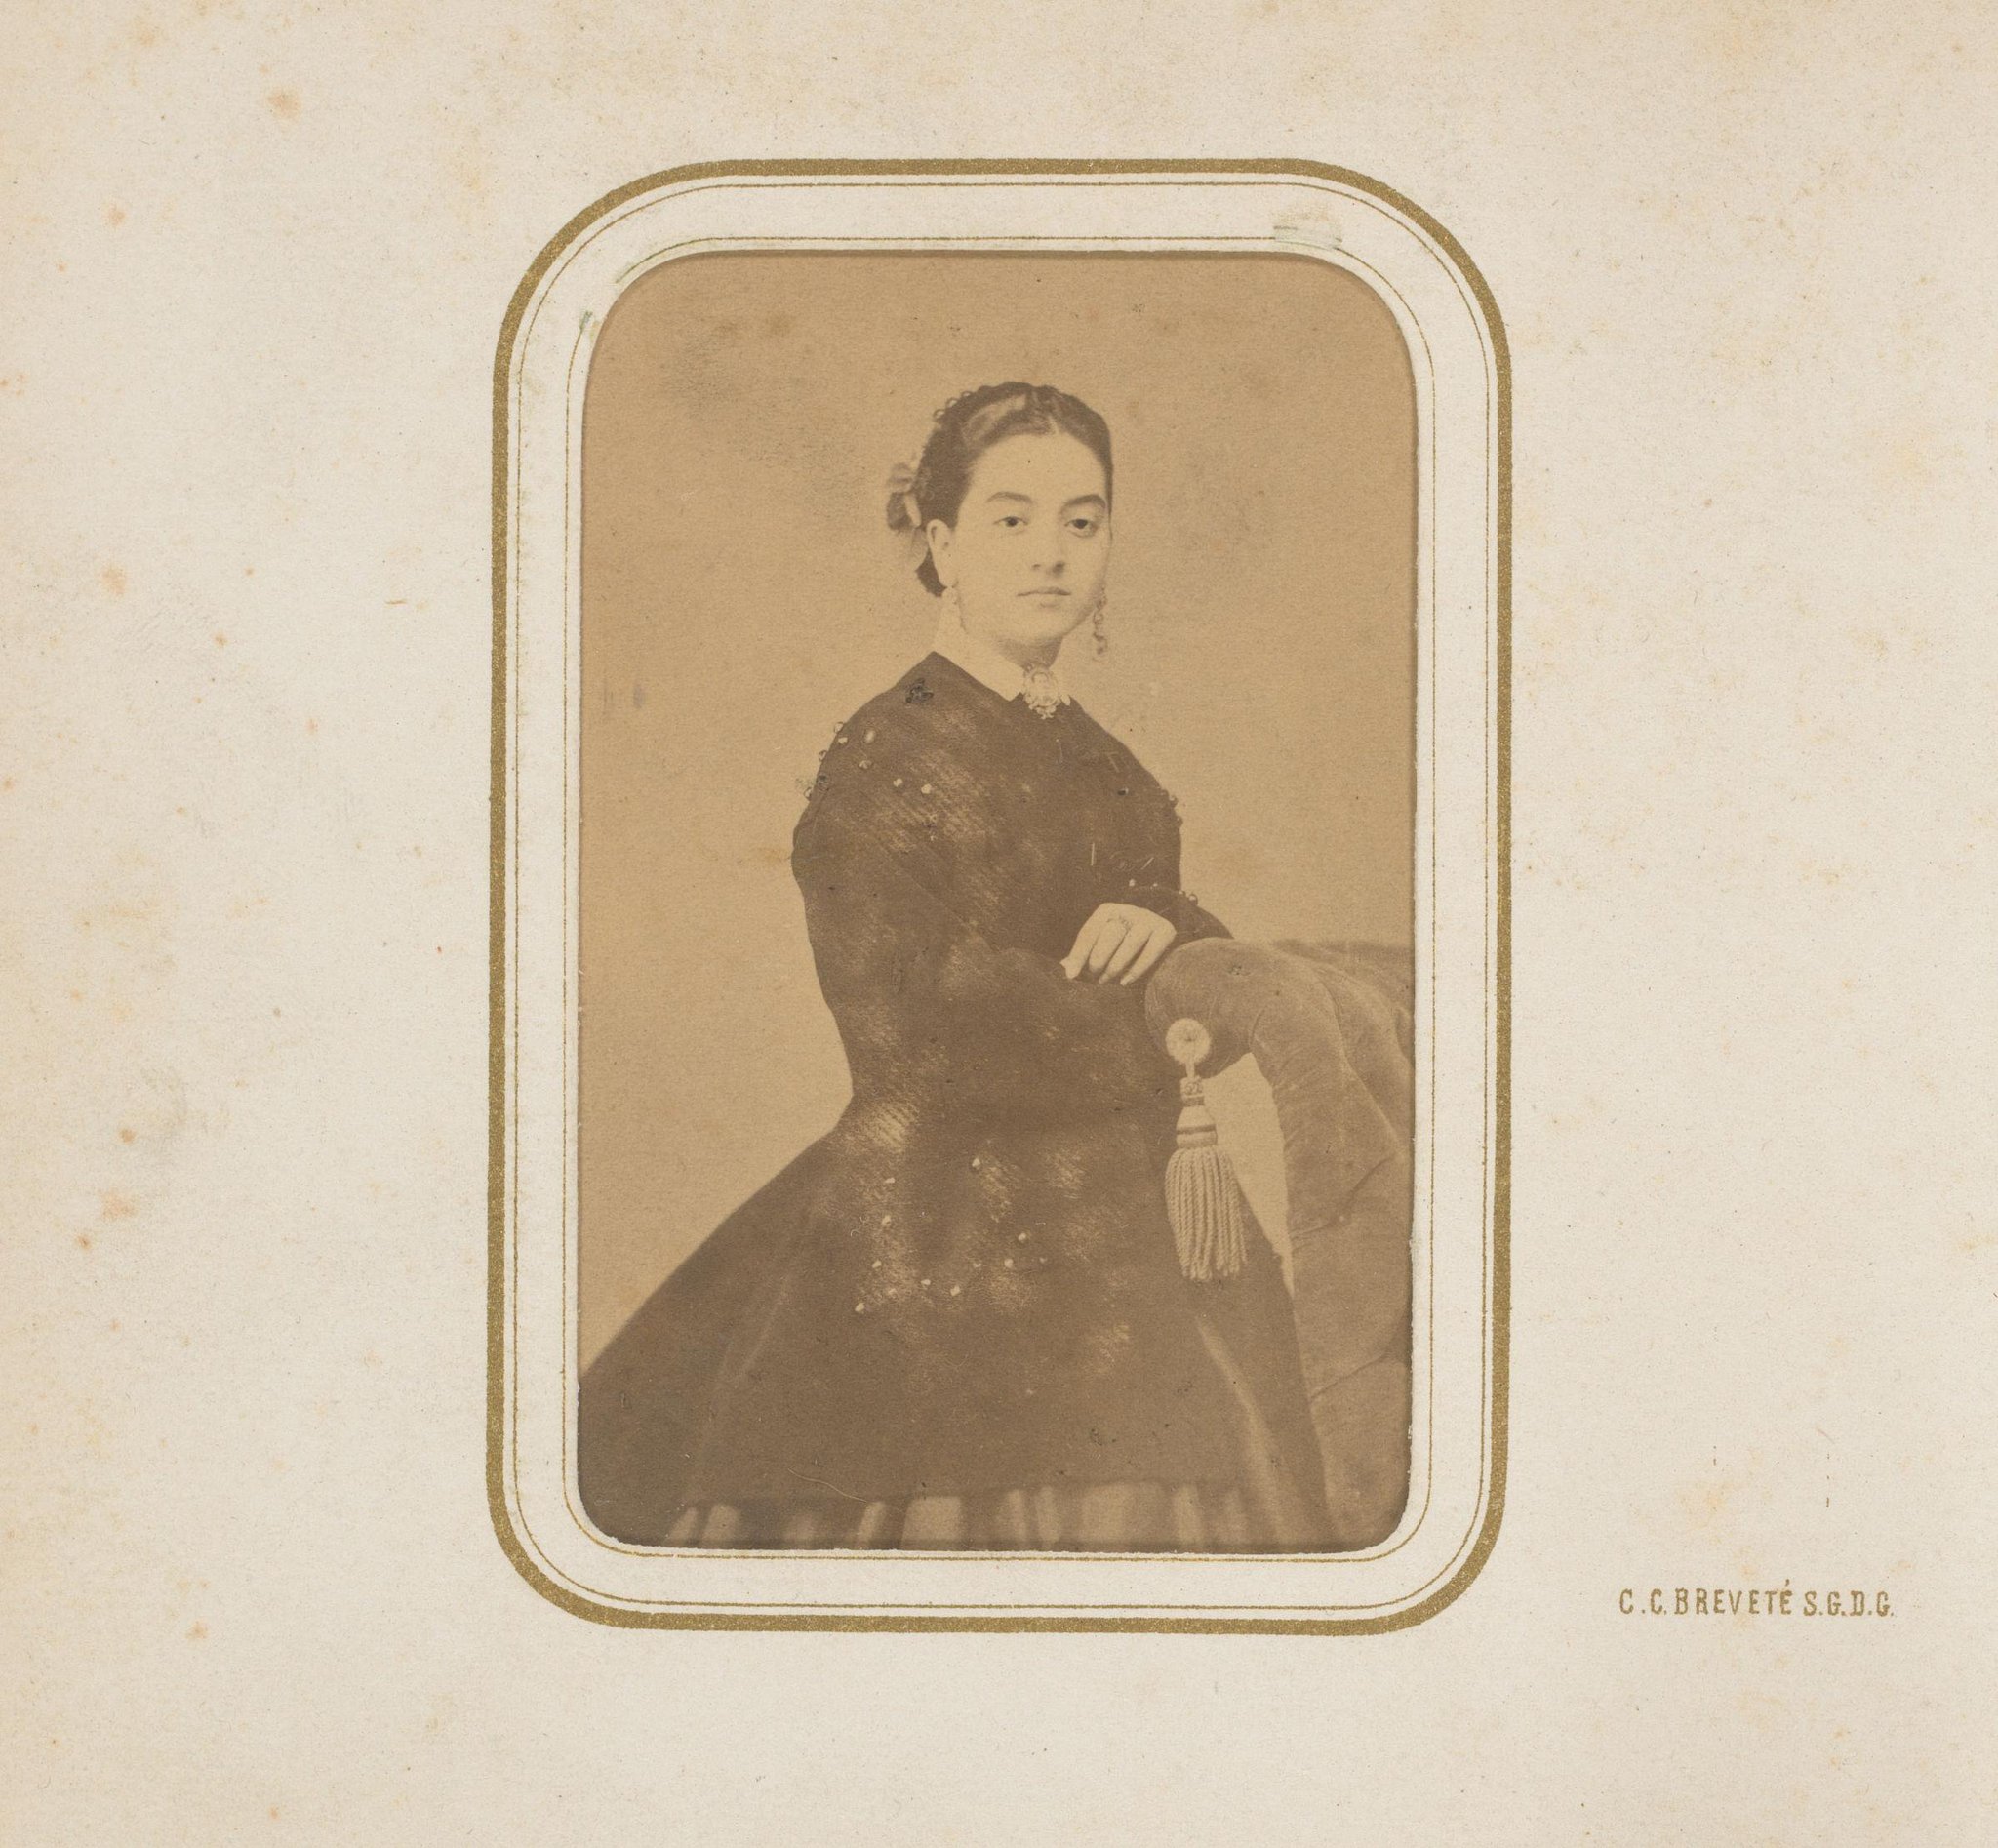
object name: carte de visite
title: Portret van een jonge vrouw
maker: josé garcía ayola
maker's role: fotograaf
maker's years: 1836-1900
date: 1860-1900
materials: cardboard, photographic support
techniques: albumen print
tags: adolescent, young woman, maiden, historical persons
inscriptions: inscription: ‘J. G. Ayola/ Granada’